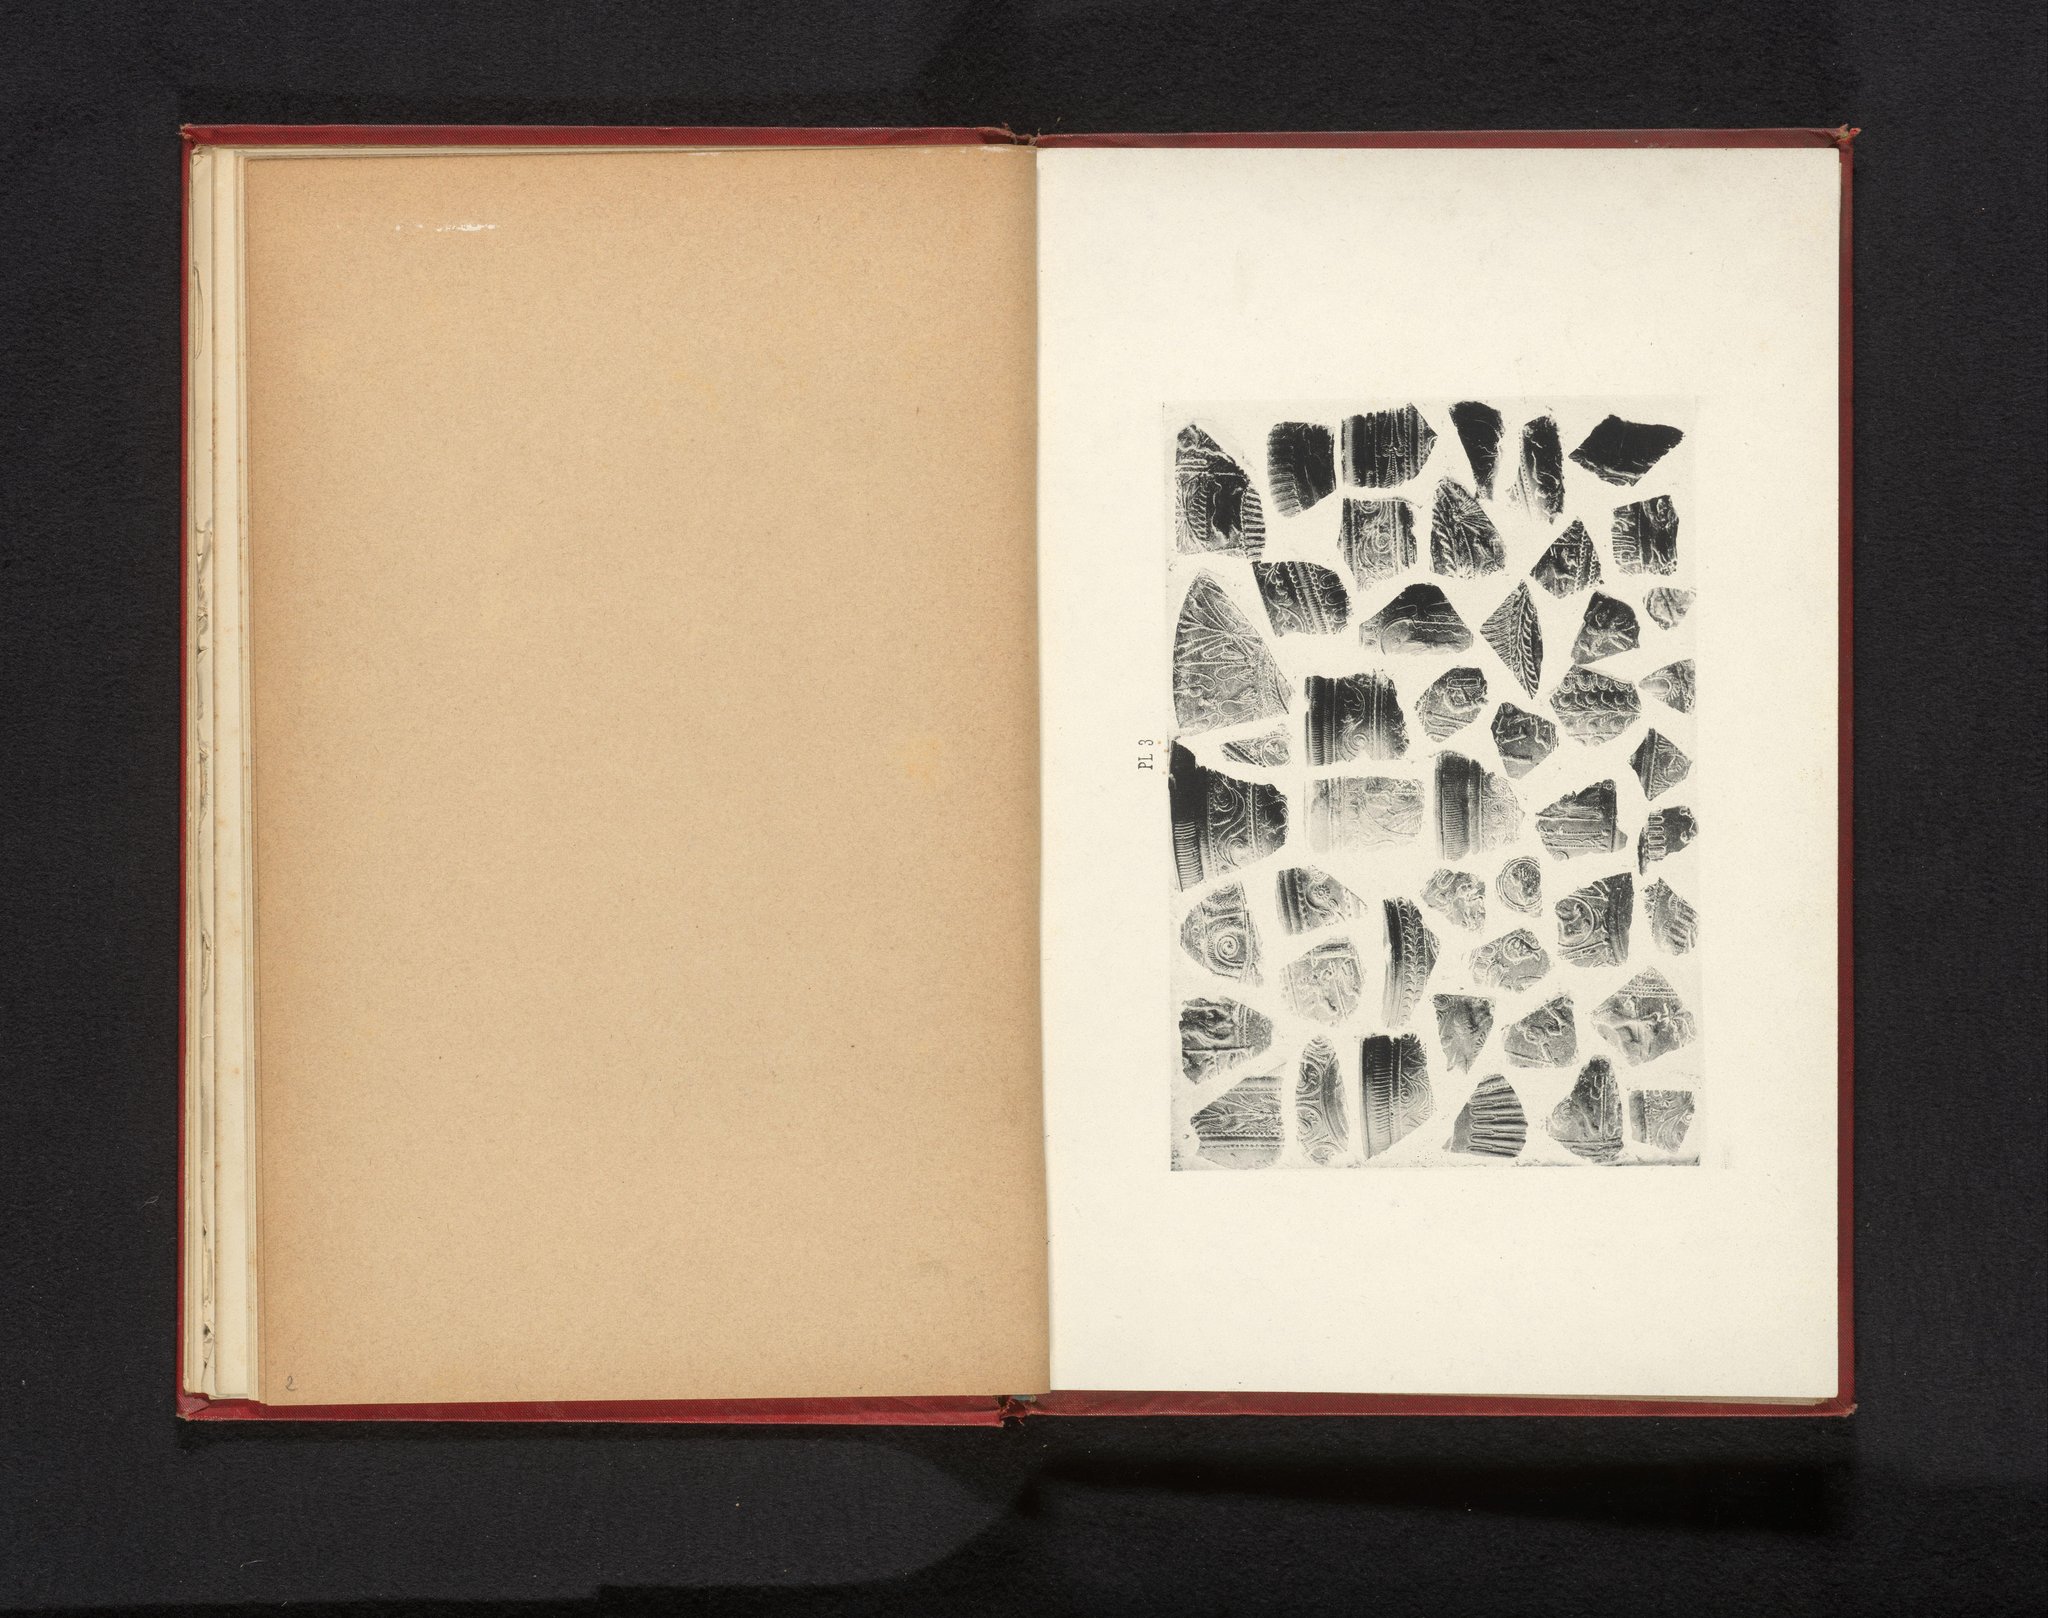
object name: page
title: Uitstalling van aardewerken scherven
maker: Anonymous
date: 1880-1881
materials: paper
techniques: photograph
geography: barcelona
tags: breaking something, container of ceramics: jar, jug, pot, vase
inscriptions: number: ‘Pl 3’